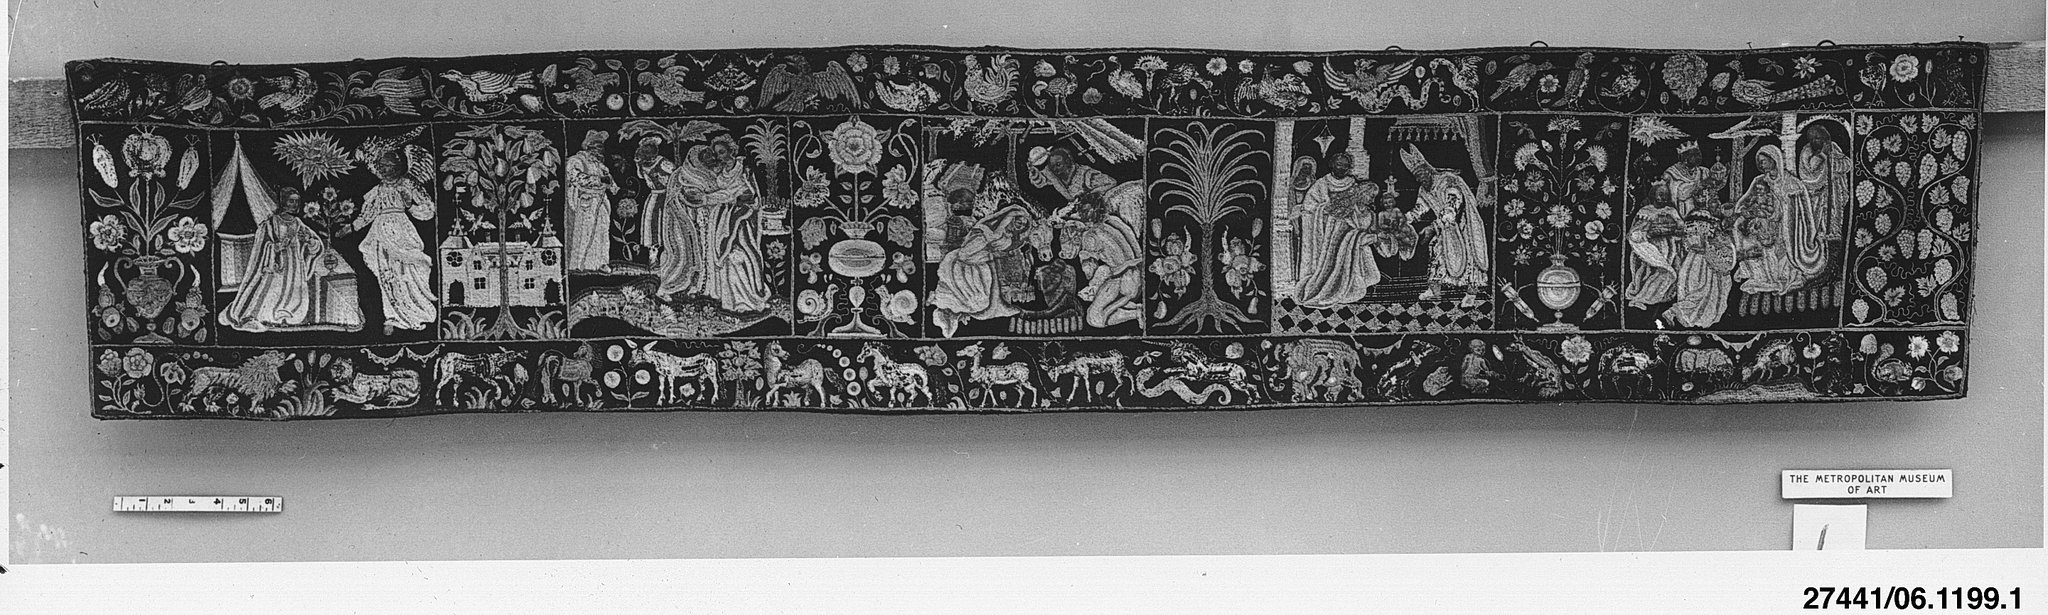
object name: border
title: Border with scenes from the Life of Christ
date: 1627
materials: silk, wool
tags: flowers,angels,christ